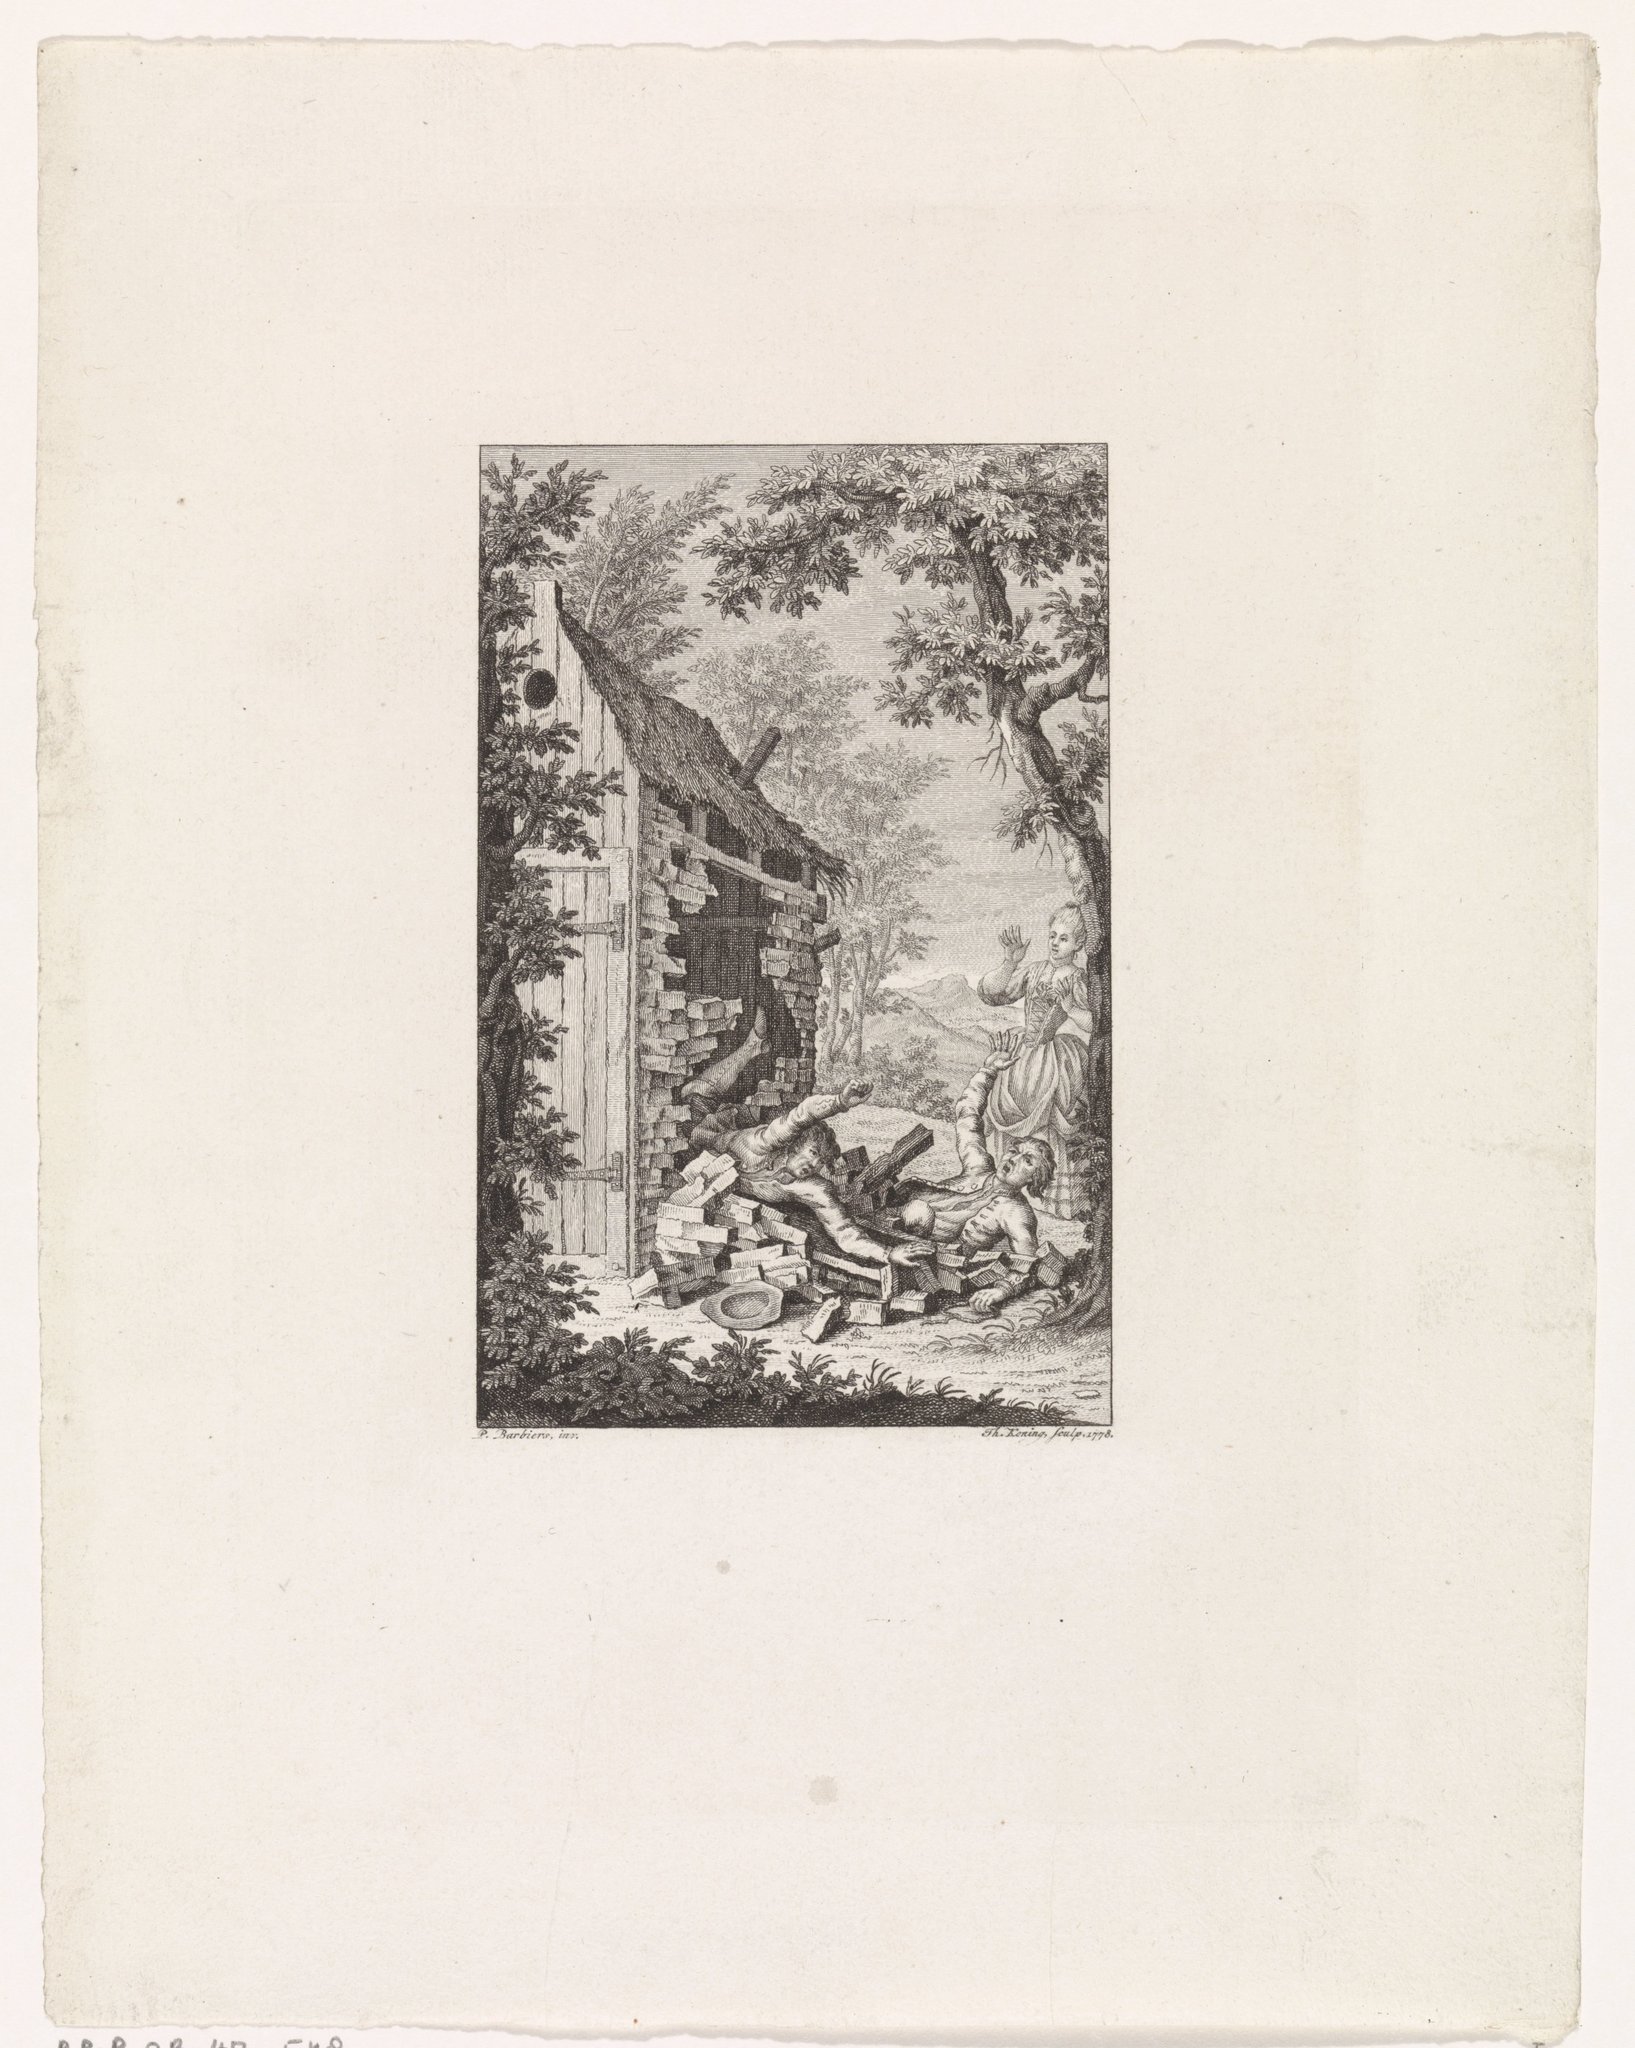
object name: print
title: Twee jagers en het melkmeisje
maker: theodoor koning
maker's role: print maker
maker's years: 1748-1829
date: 1778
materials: paper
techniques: engraving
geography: amsterdam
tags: hunter, milkmaid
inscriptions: collector's mark: Lugt 2228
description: Twee jagers vallen door de muur van een schuurtje naar buiten en laten daardoor de jonge vrouw bij de boom schrikken. Deze afbeelding vertoont een scène uit de klucht 'De twee jaagers en het melkmeisje'.